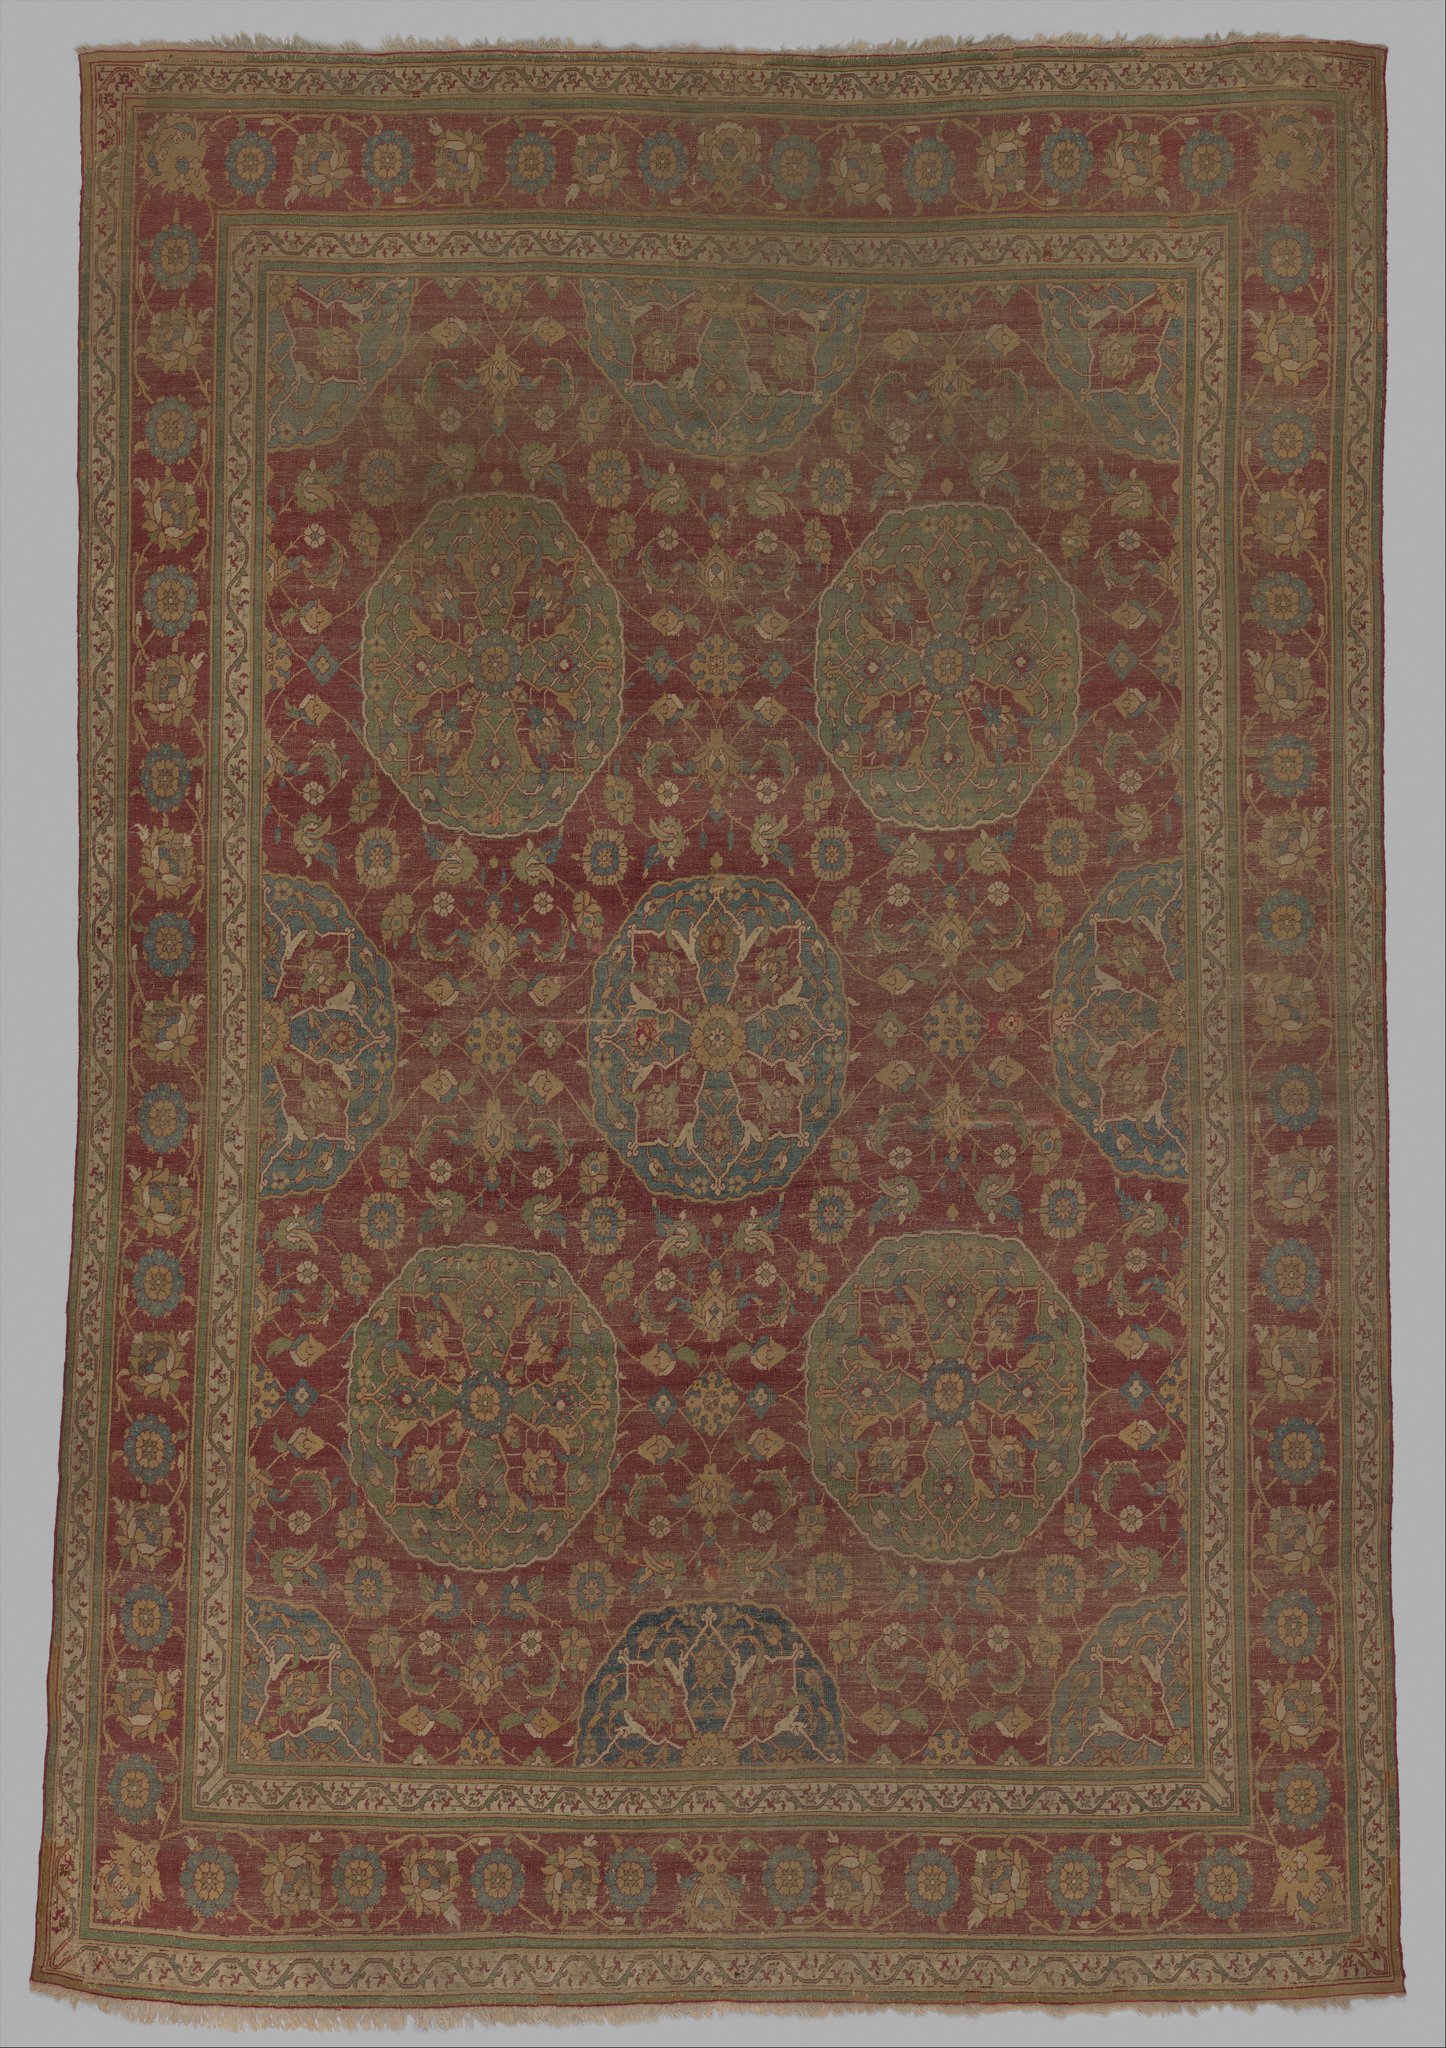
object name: carpet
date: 1601-1700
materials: wool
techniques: asymmetrically knotted pile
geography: egypt